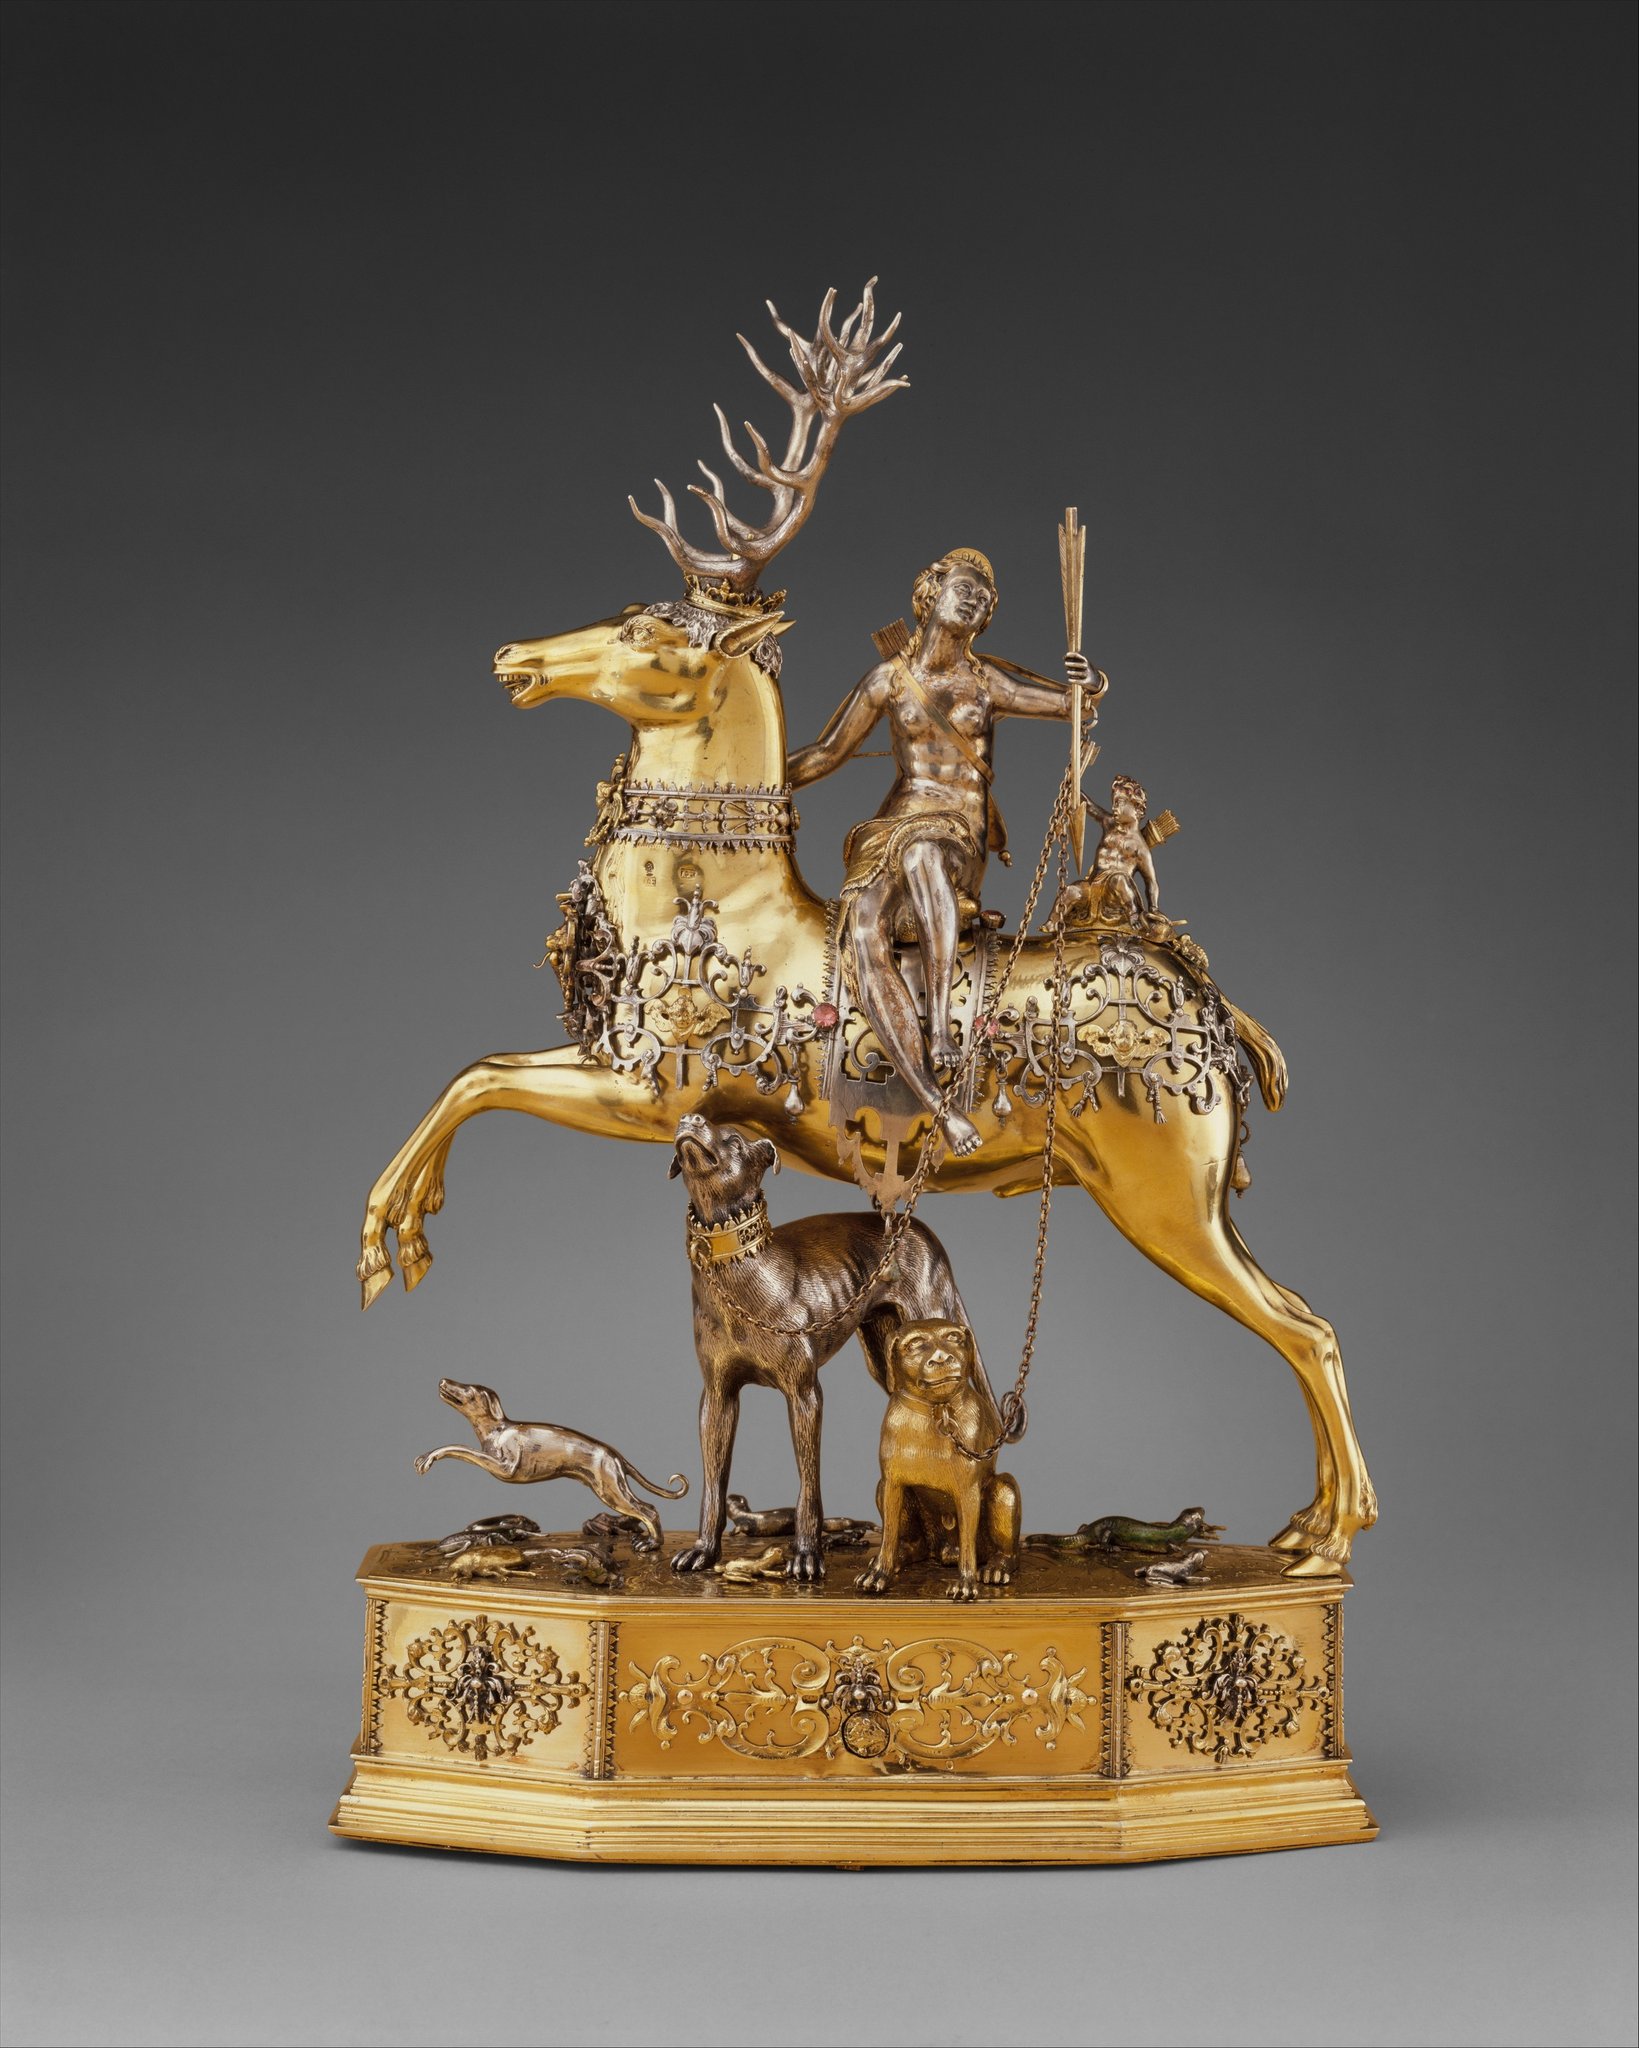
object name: automaton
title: Diana and the Stag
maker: joachim friess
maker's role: maker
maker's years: 1579-1620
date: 1620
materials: enamel, gilt silver, iron, wood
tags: cupid,diana,deer,dogs,frogs,insects,lizards